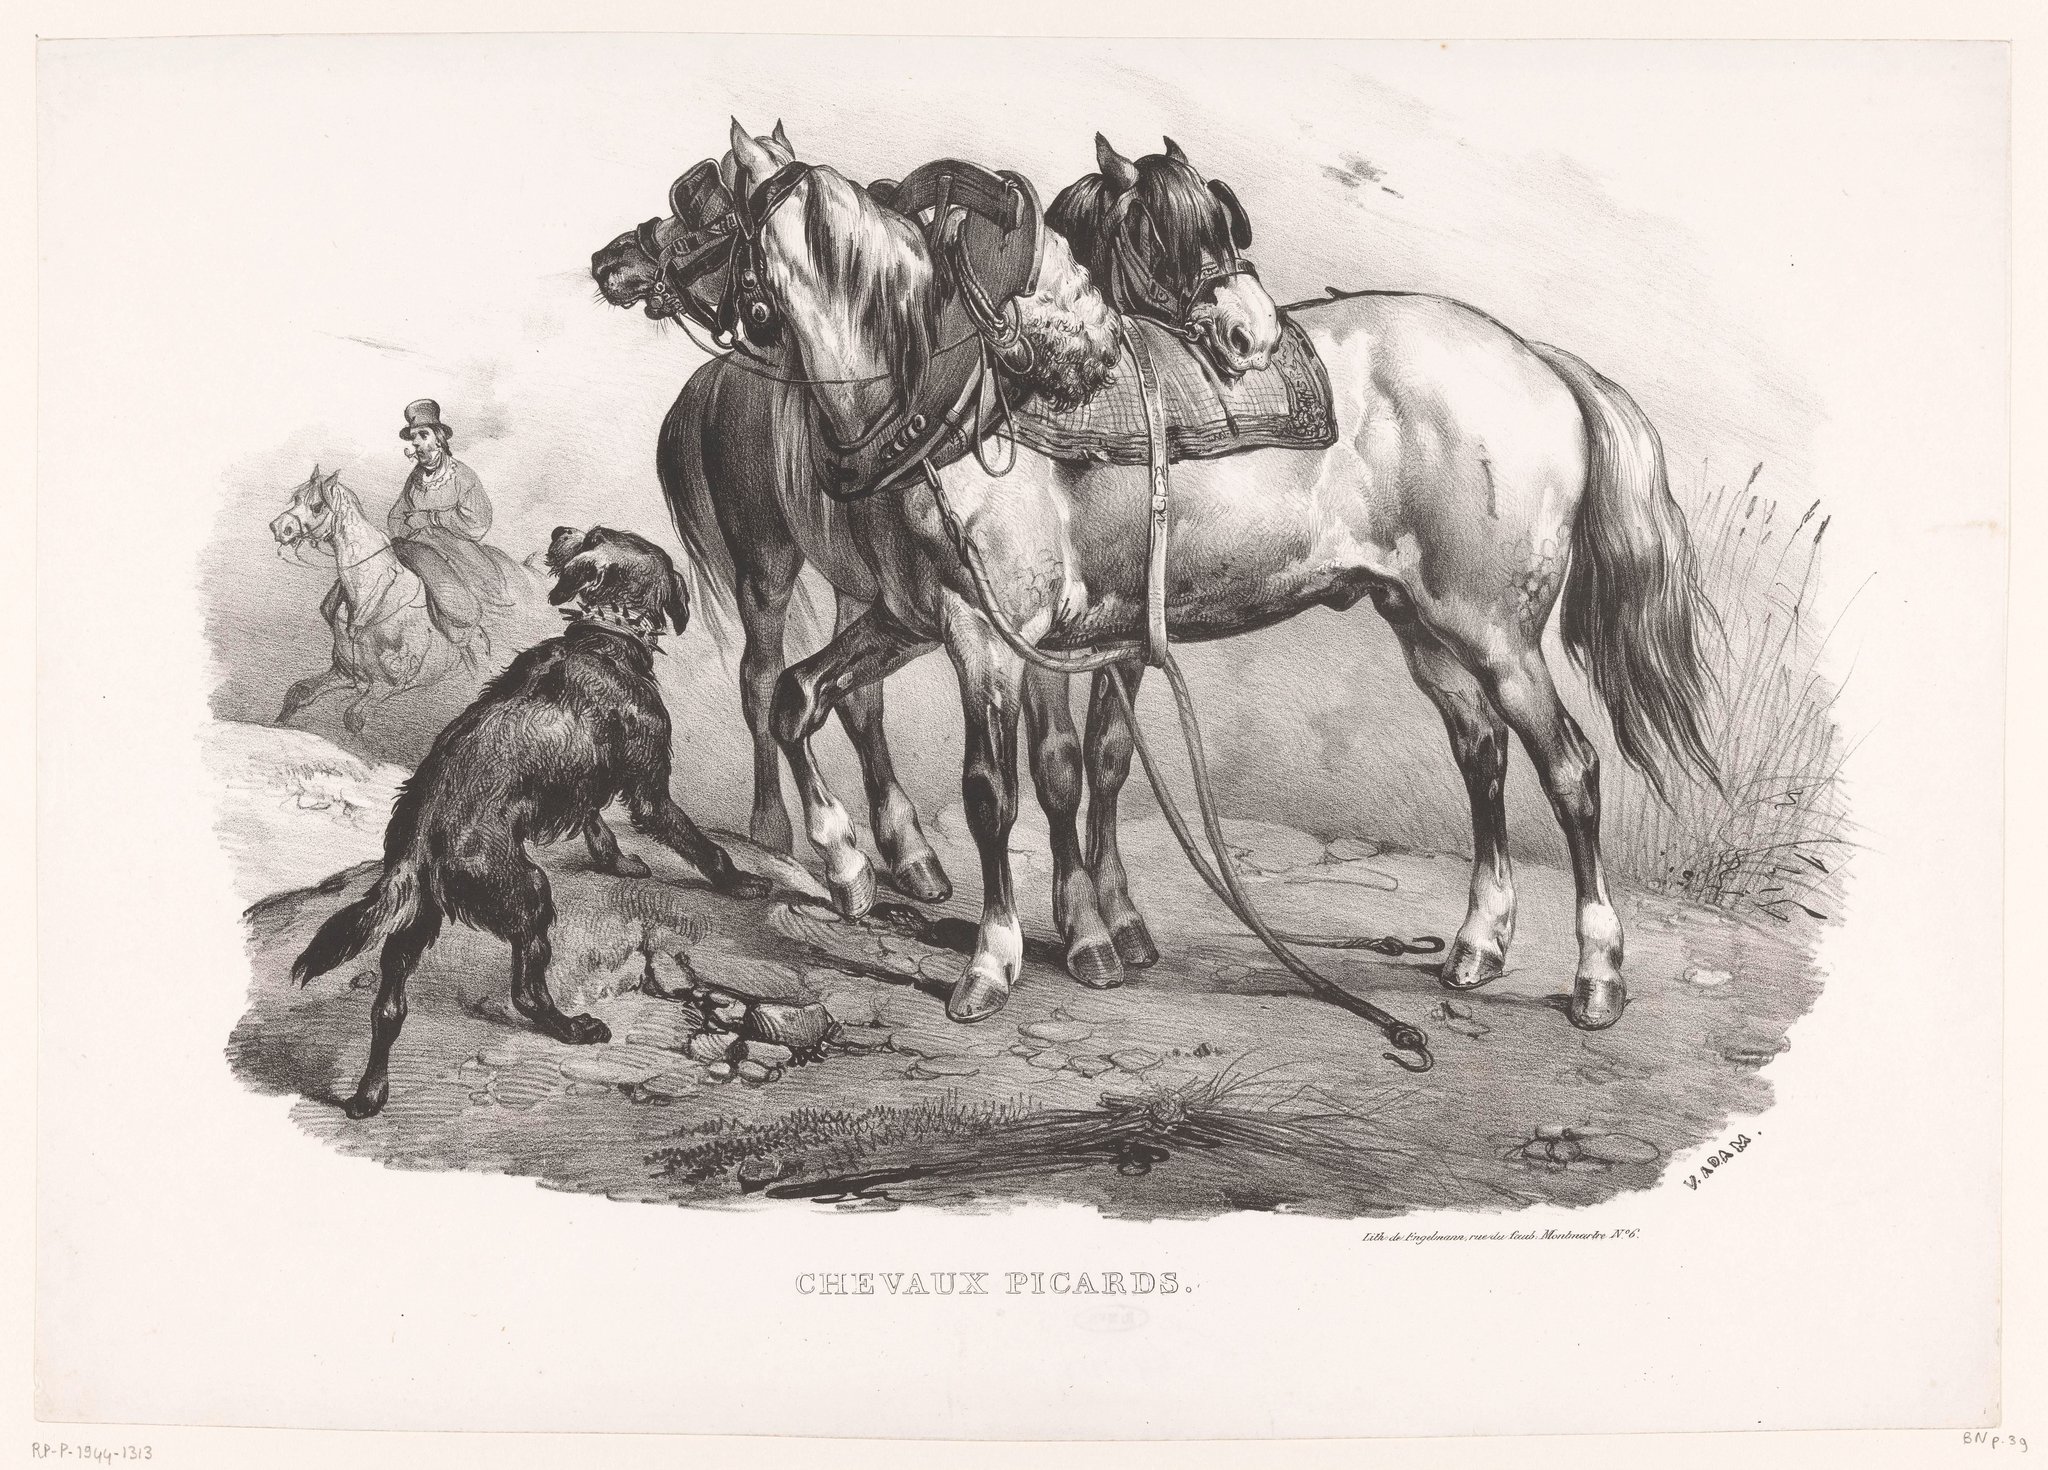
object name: print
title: Chevaux picards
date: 1829-1830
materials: paper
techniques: lithograph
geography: france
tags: horse, dog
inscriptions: collector's mark: Lugt 2228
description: De prent is mogelijk de negentiende prent binnen een serie van 24 prenten.